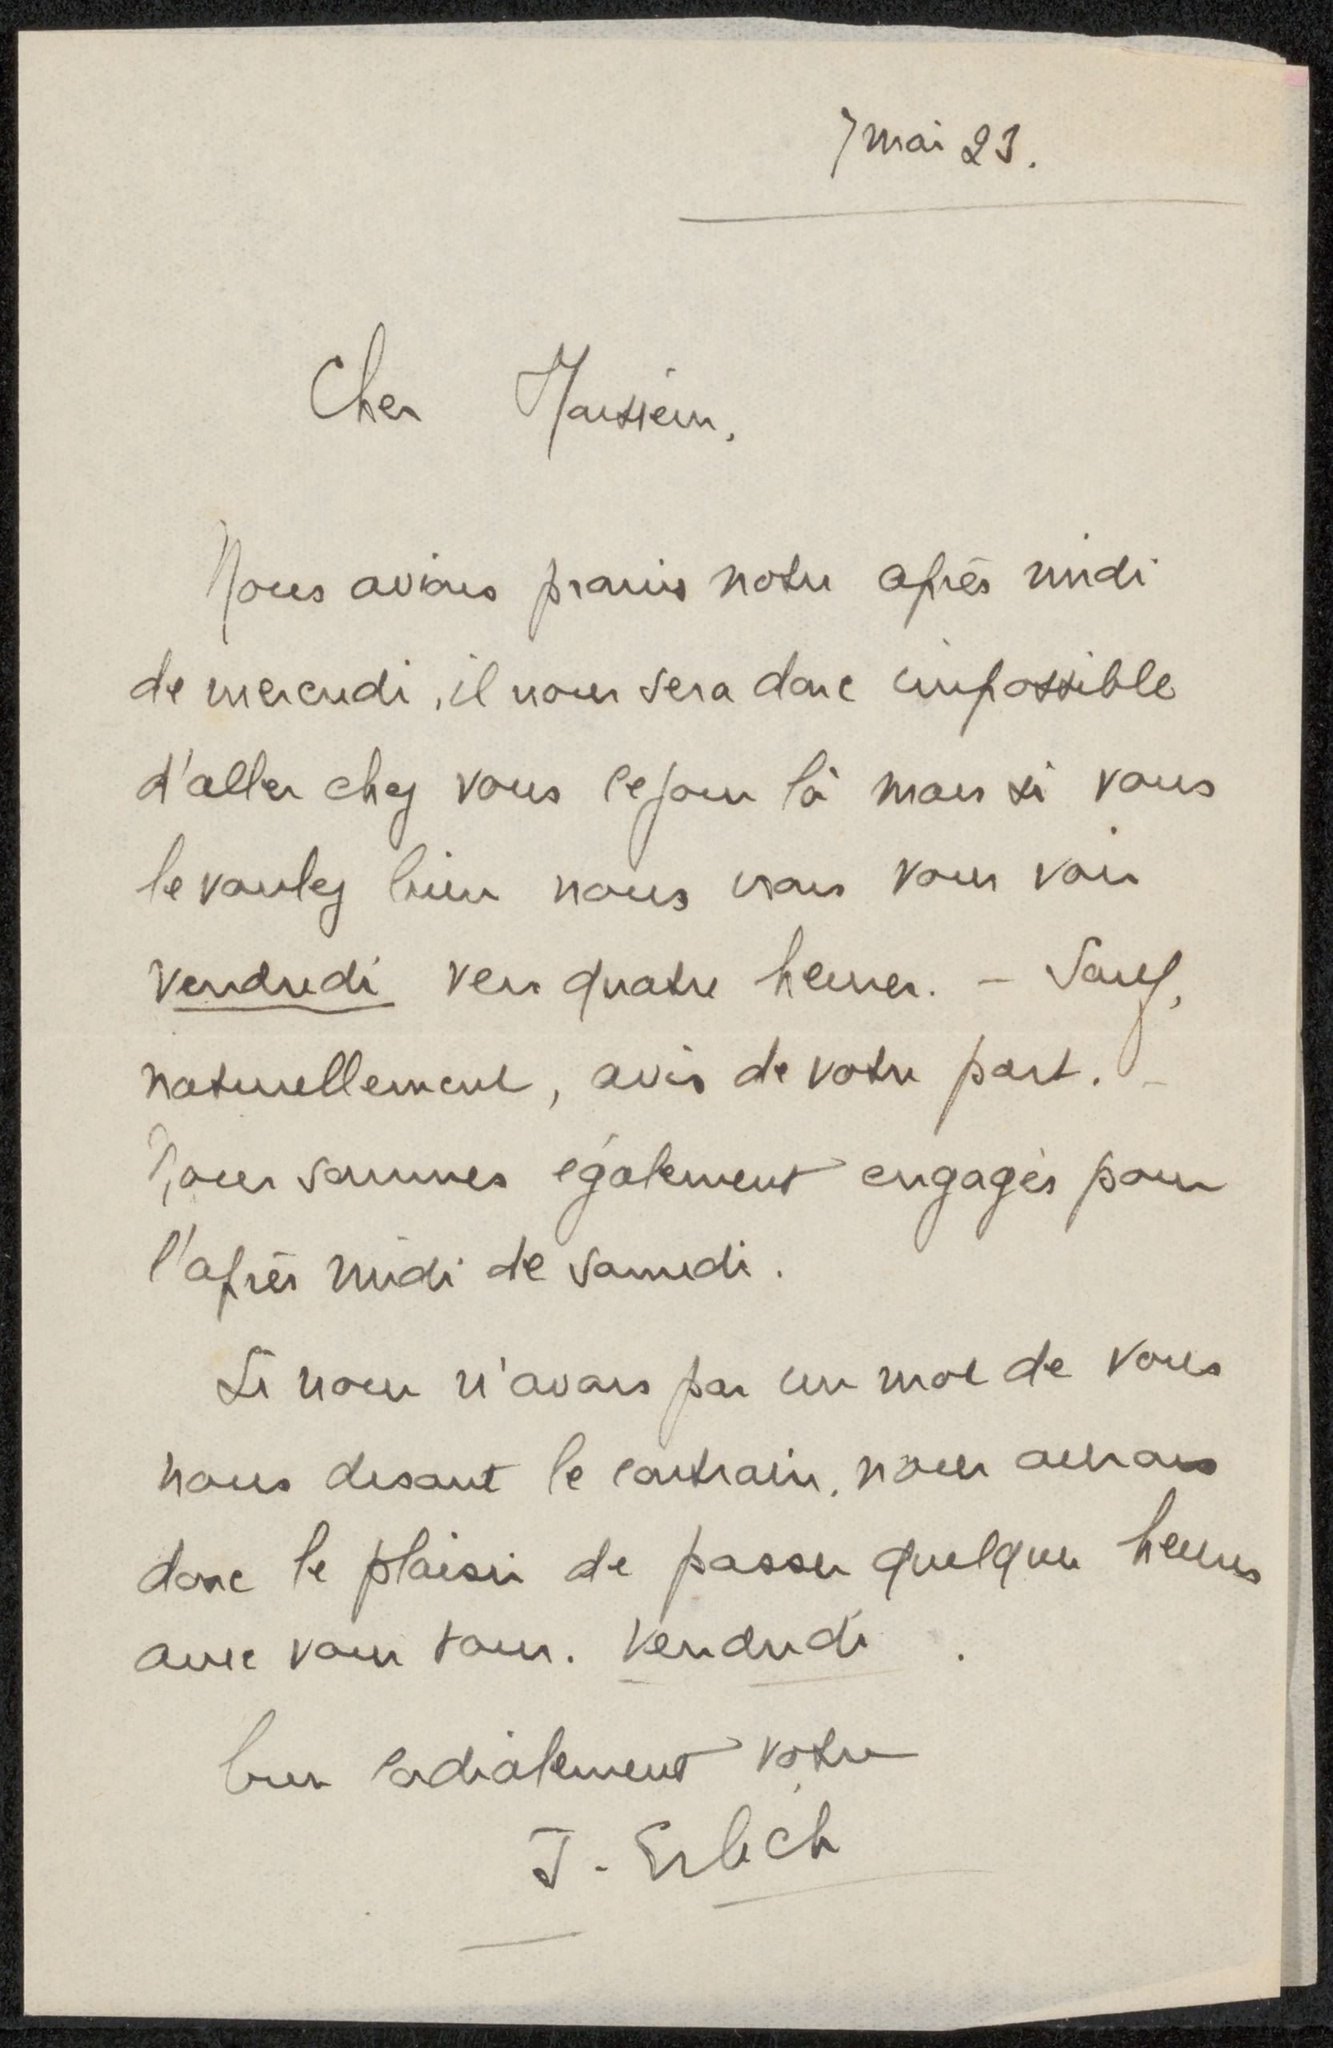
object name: letter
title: Brief aan Philip Zilcken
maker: jeanne erlich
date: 1923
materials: ink, paper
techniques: pen, writing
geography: nice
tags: the hague, painter, philip zilcken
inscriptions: collector's mark: ‘RPK’